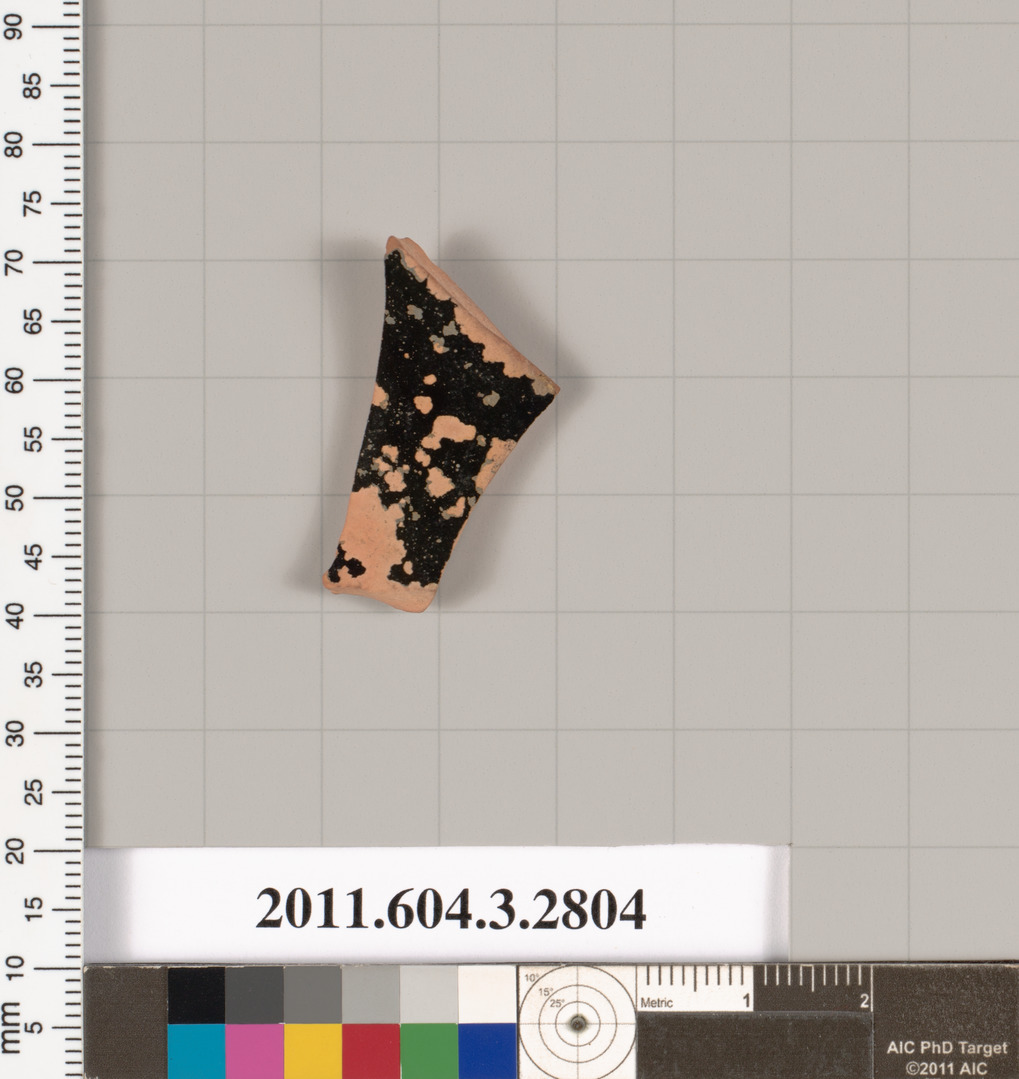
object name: olpe fragment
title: Terracotta fragment of an olpe (jug)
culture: greek, attic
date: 600-401 BCE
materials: terracotta